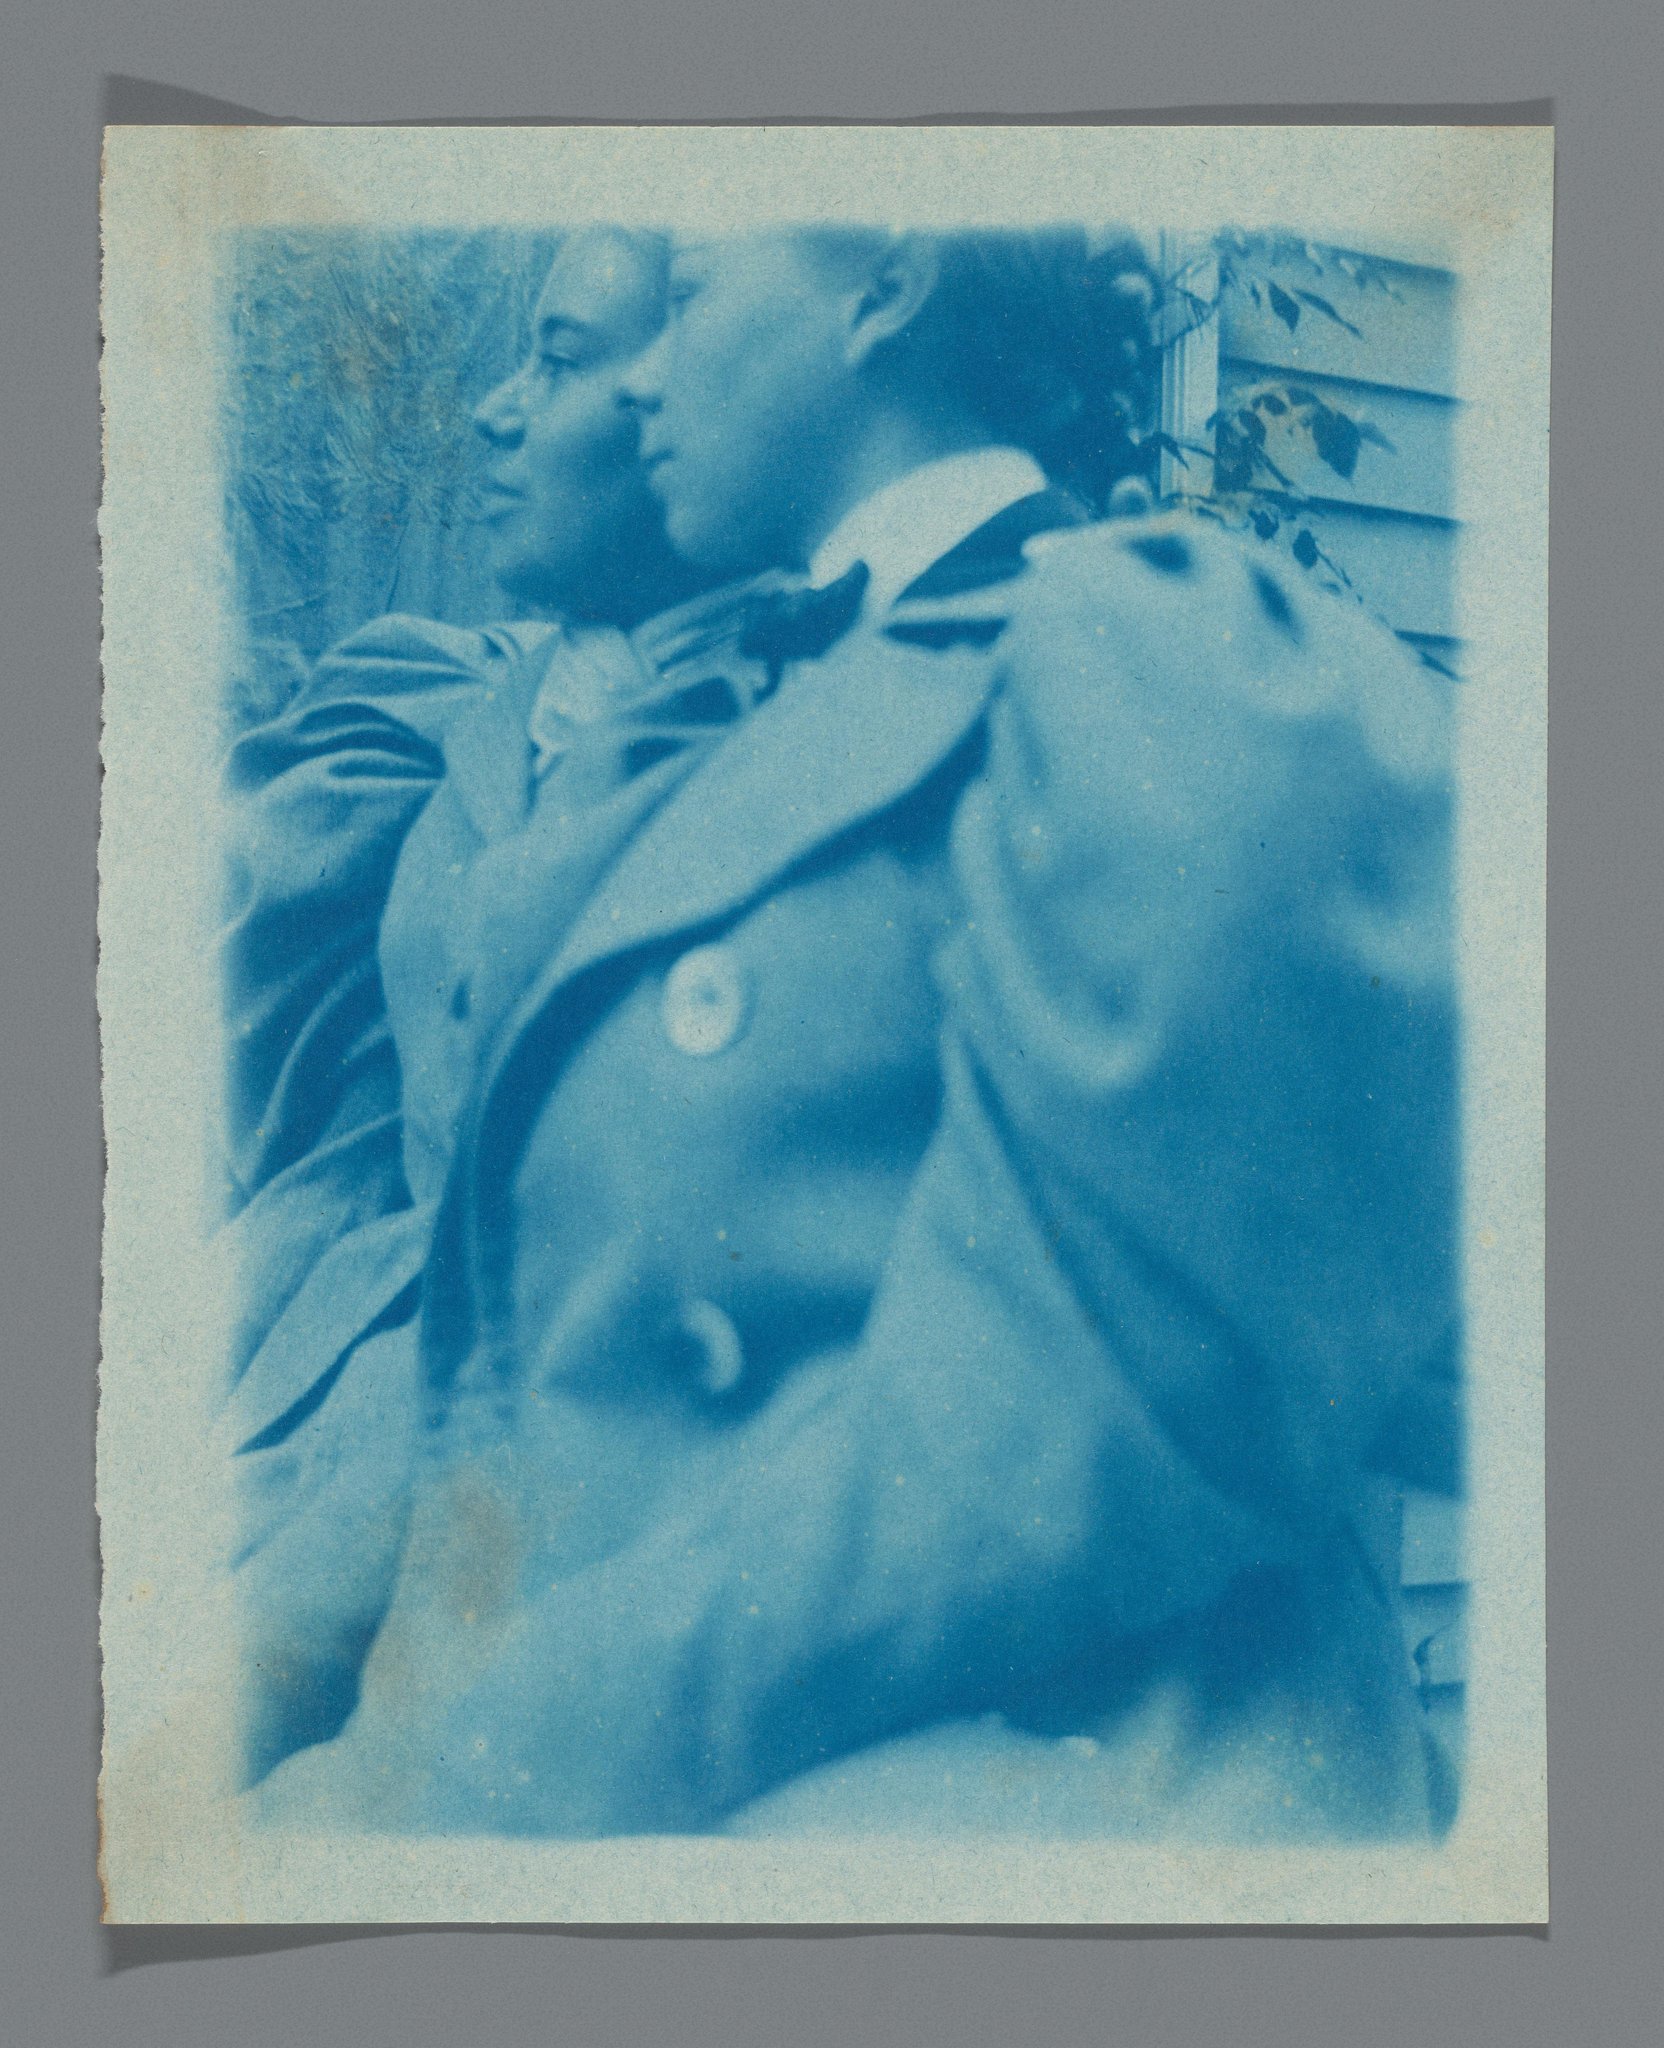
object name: photograph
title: Portret van twee vrouwen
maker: Anonymous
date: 1900-1930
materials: photographic support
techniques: cyanotype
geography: united states